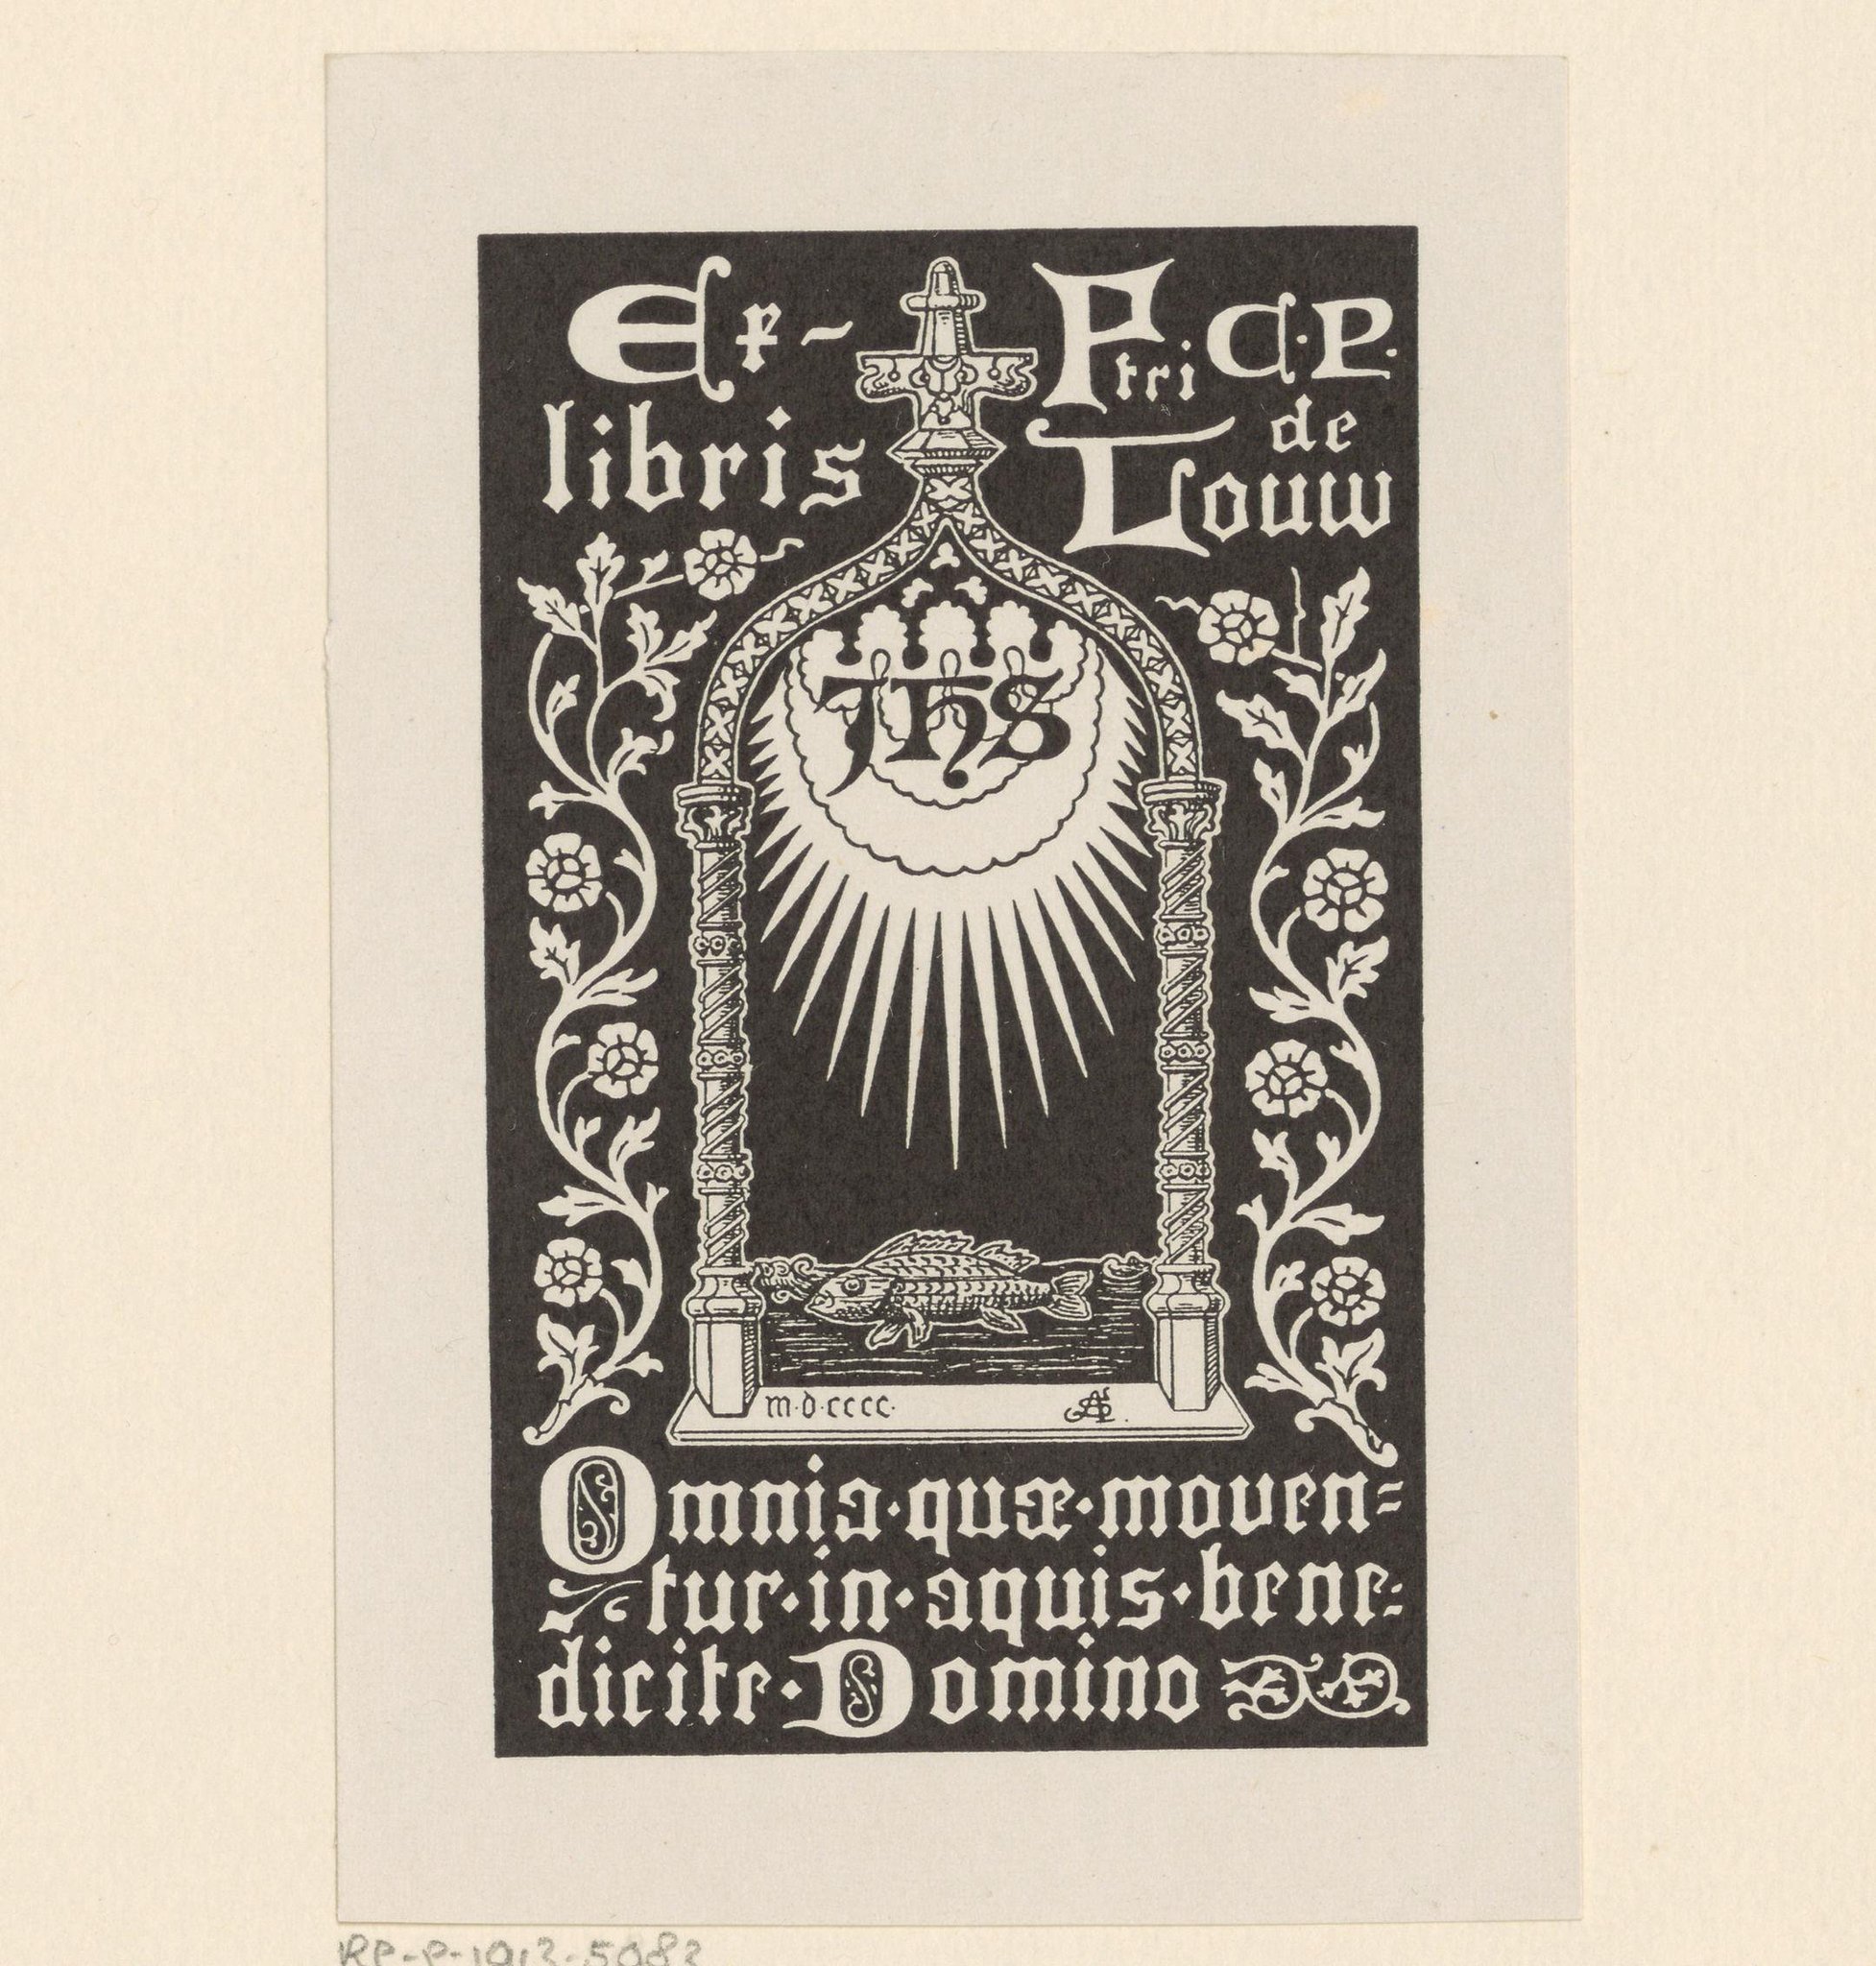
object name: bookplate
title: Ex libris van P.C.P. de Louw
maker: august hendrik sassen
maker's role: print maker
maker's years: 1853-1913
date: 1900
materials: paper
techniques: printing block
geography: netherlands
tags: ihs ('iesus hominum salvator') ~ symbol of christ, fishes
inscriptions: collector's mark: Lugt 2233, collector's mark: Lugt 2760